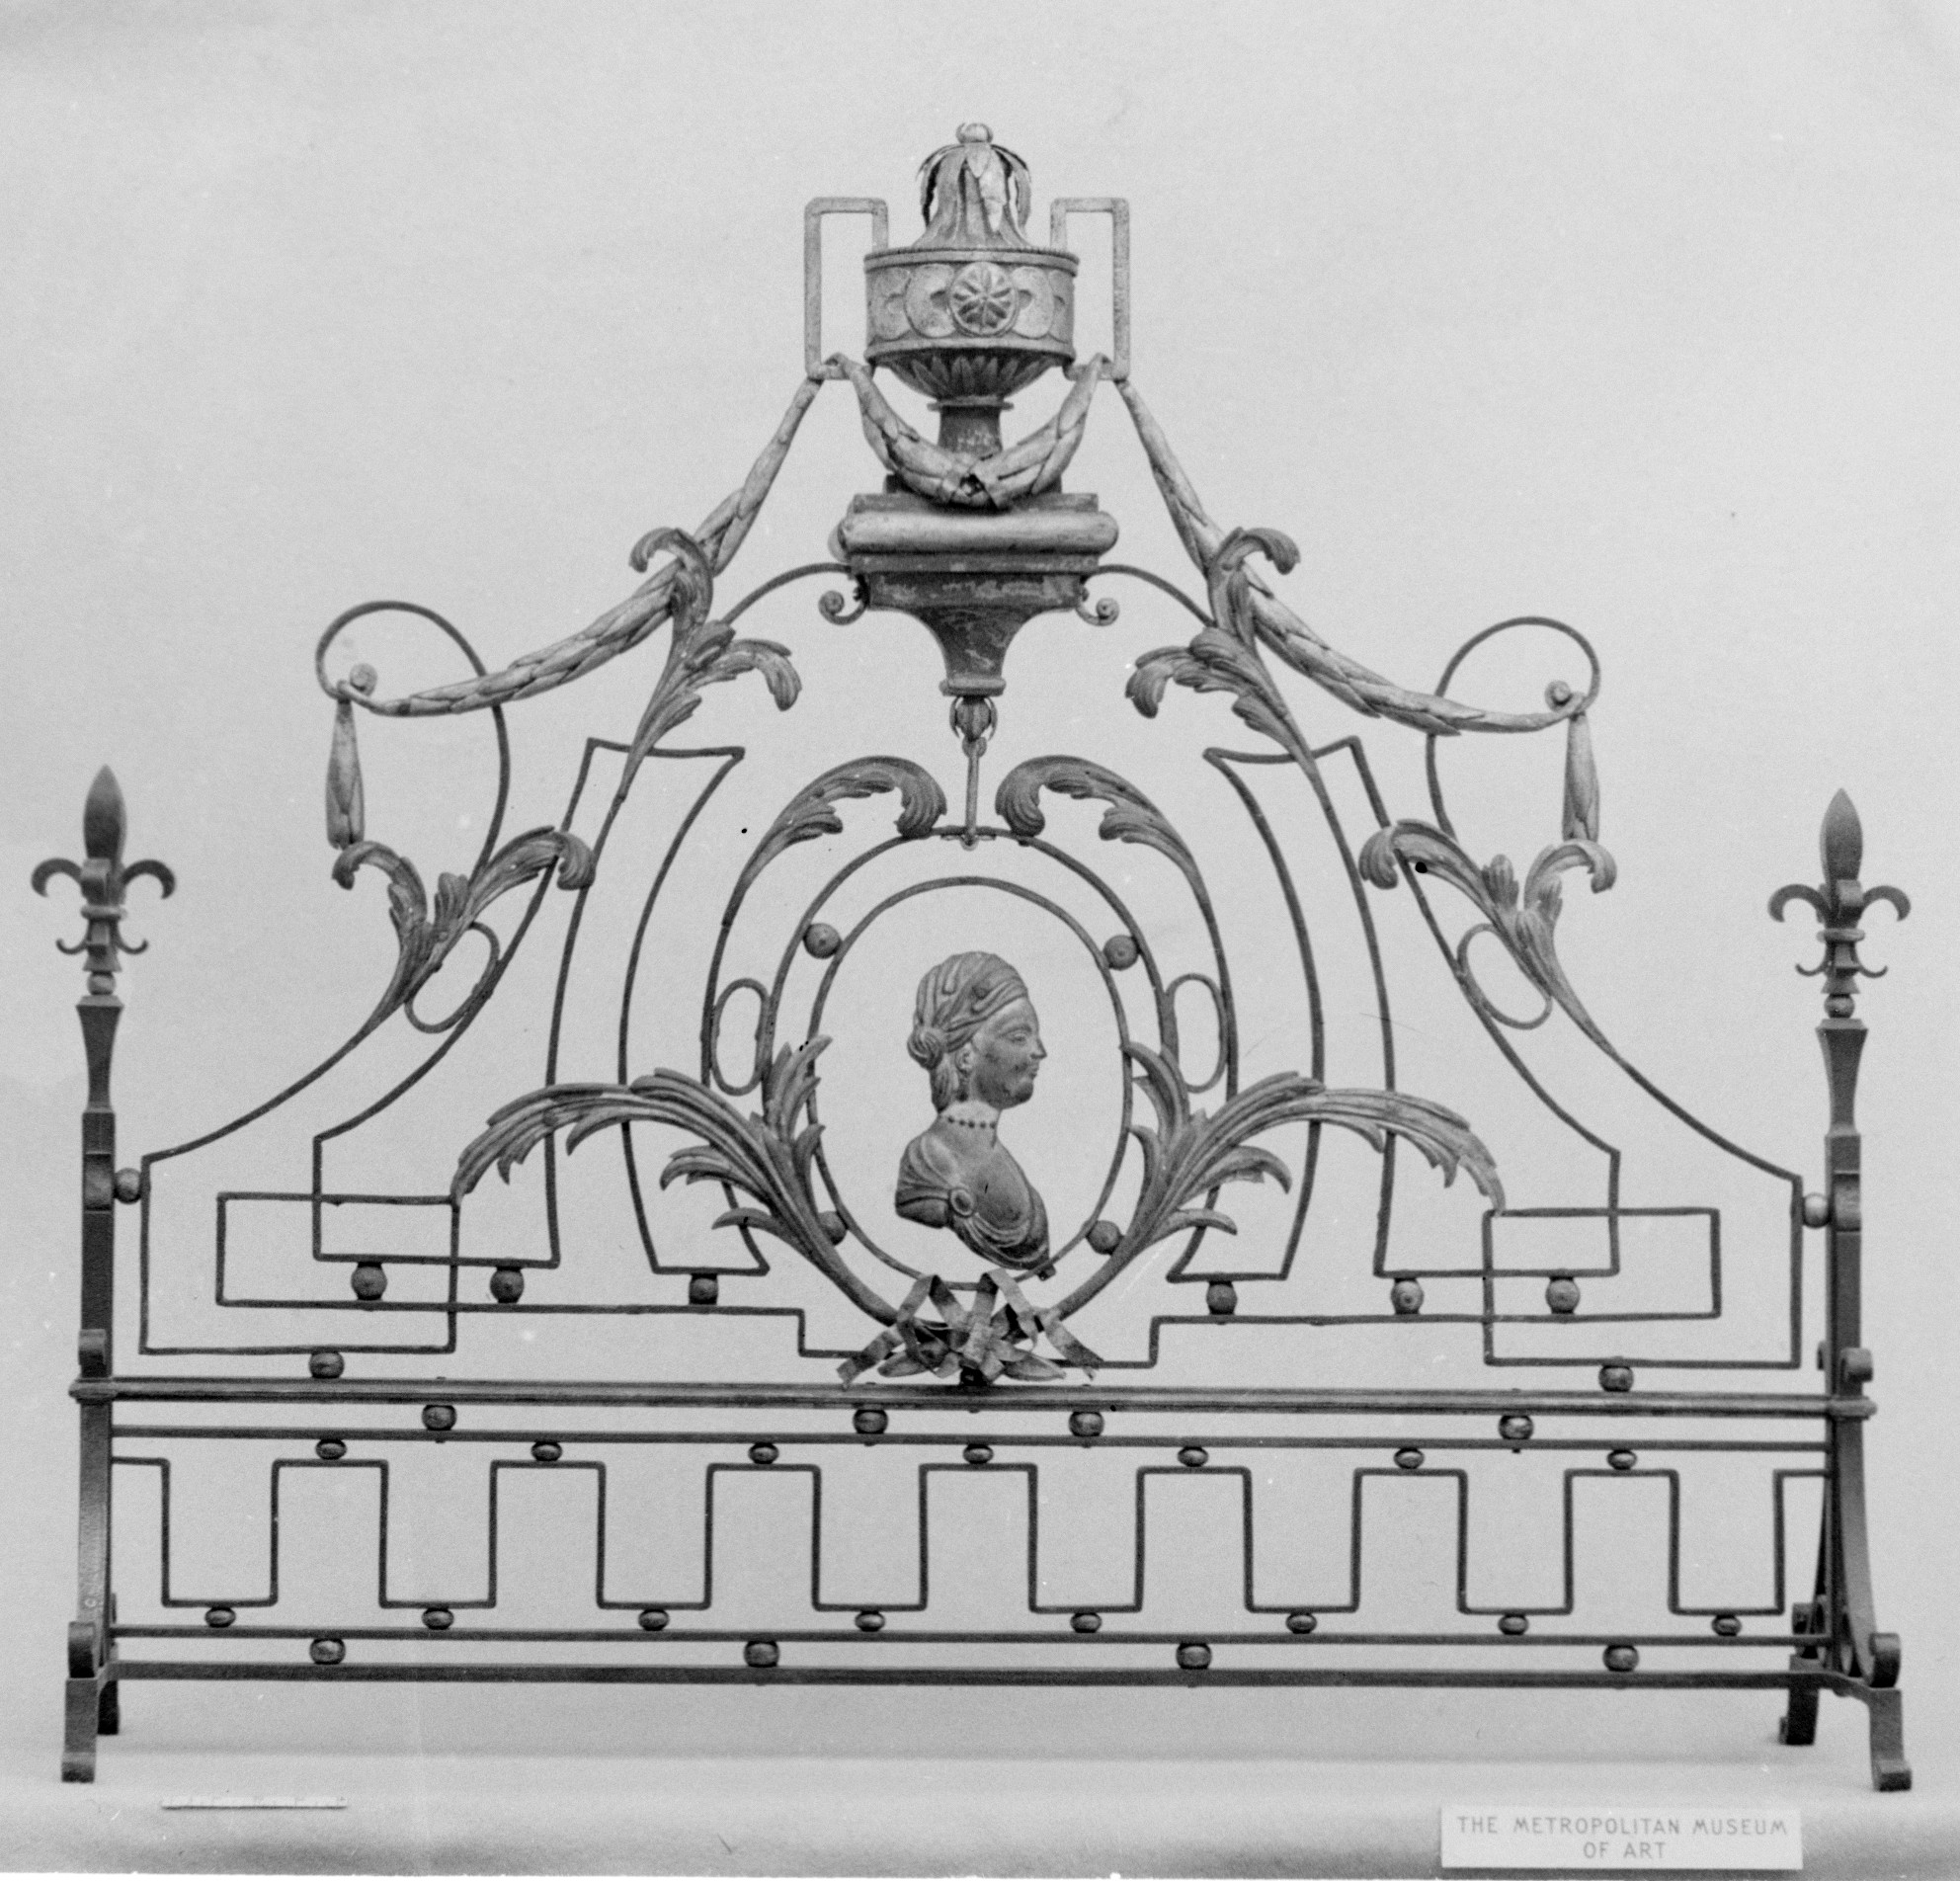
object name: screen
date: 1701-1800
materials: gilt, iron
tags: profiles